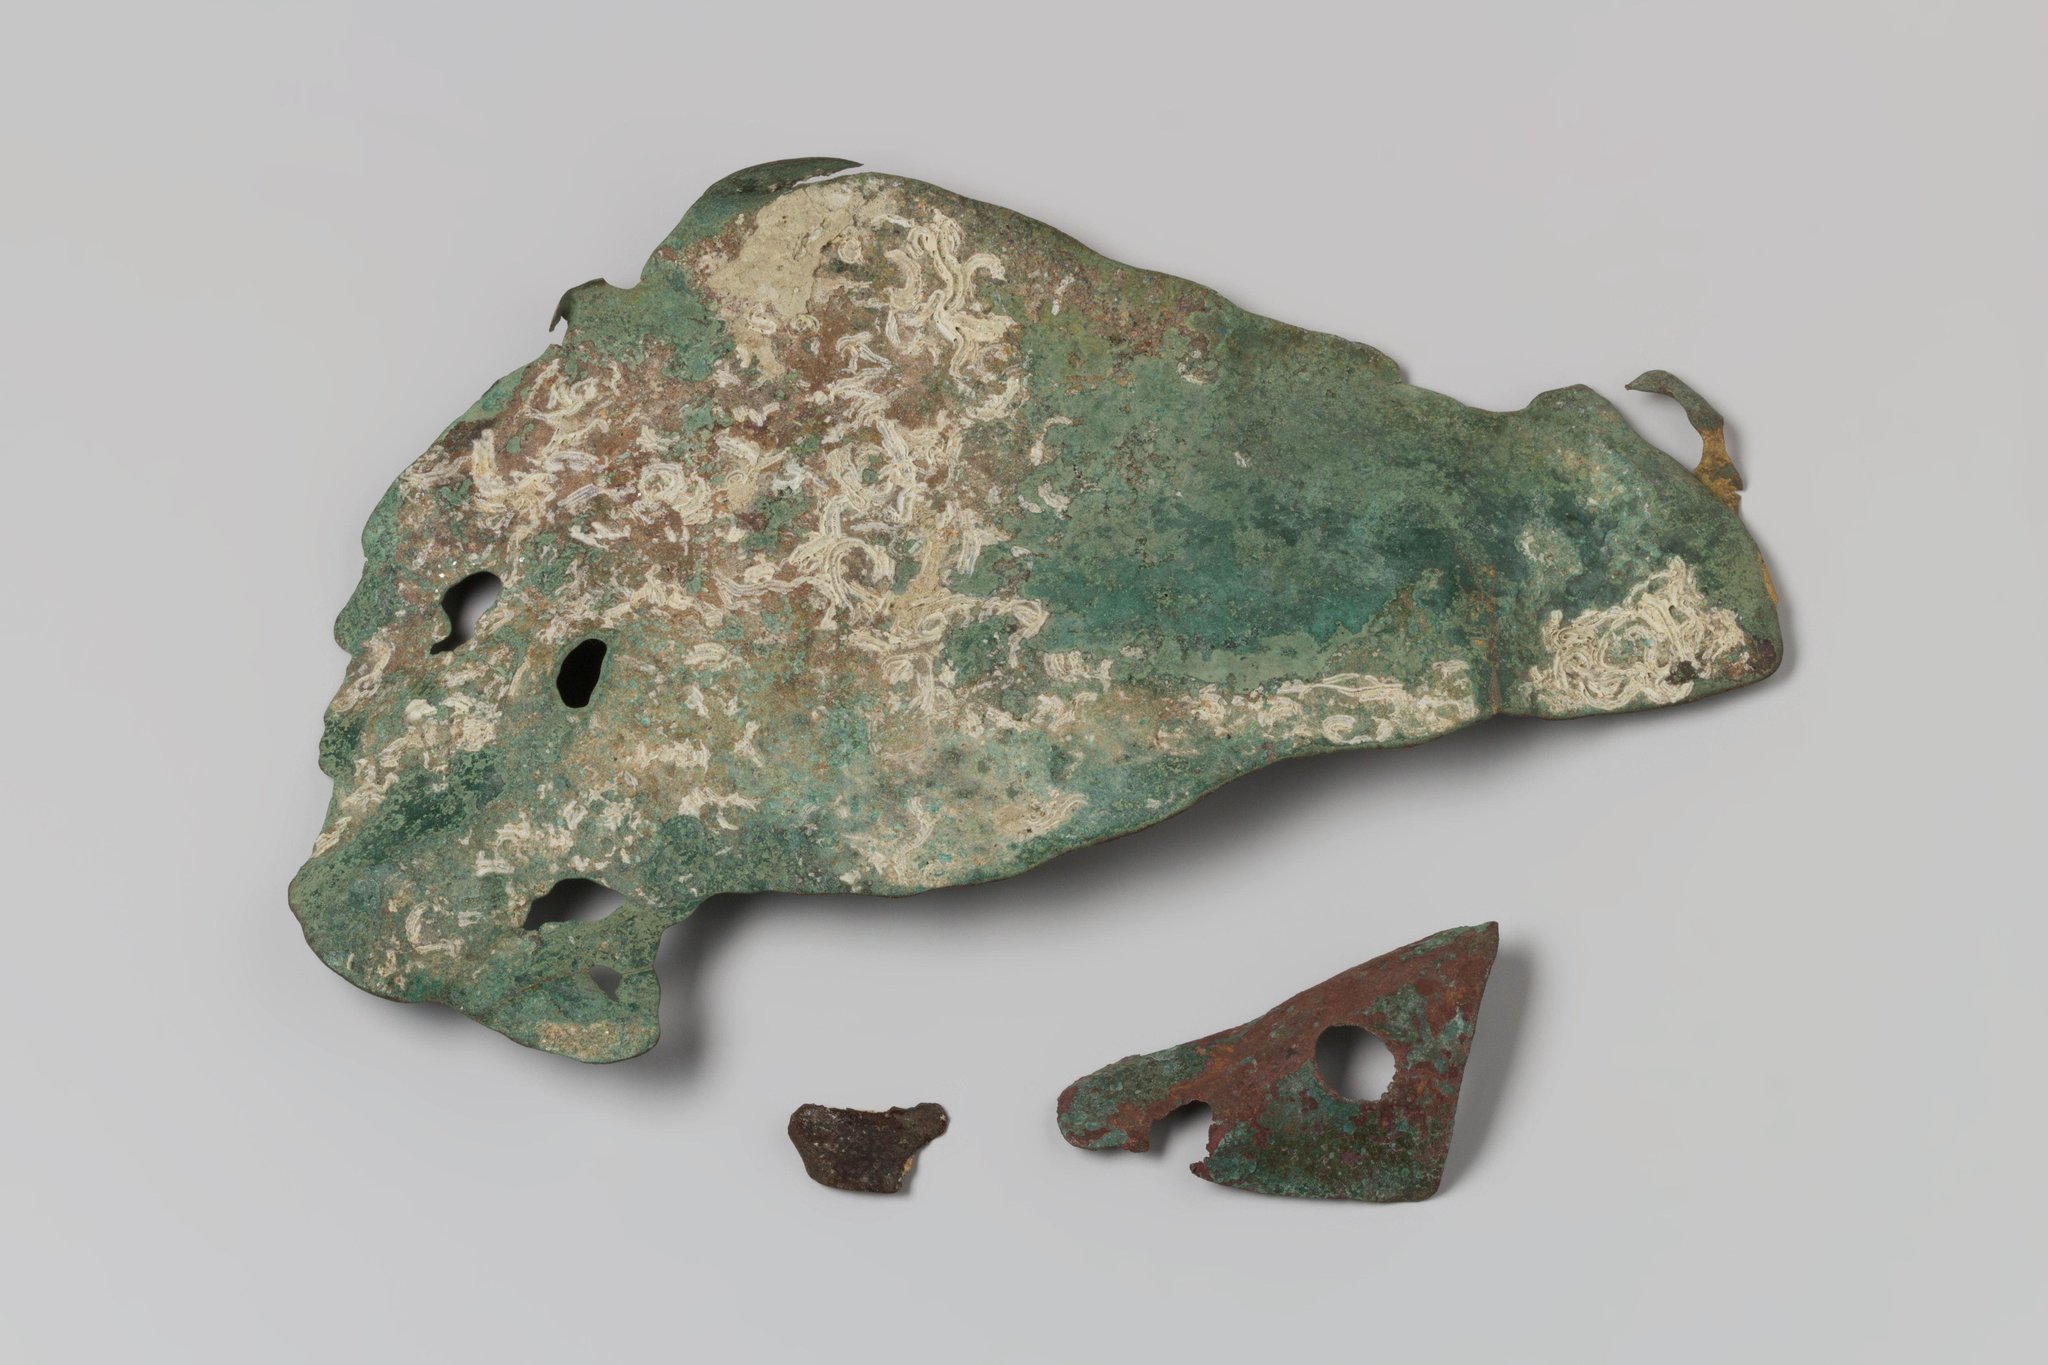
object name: scheepswrakvondst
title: Fragmenten van plaatwerk uit het wrak van de Oost-Indiëvaarder Hollandia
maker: Anonymous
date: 1700-1743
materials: copper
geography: netherlands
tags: verenigde oostindische compagnie, hollandia (schip), annet